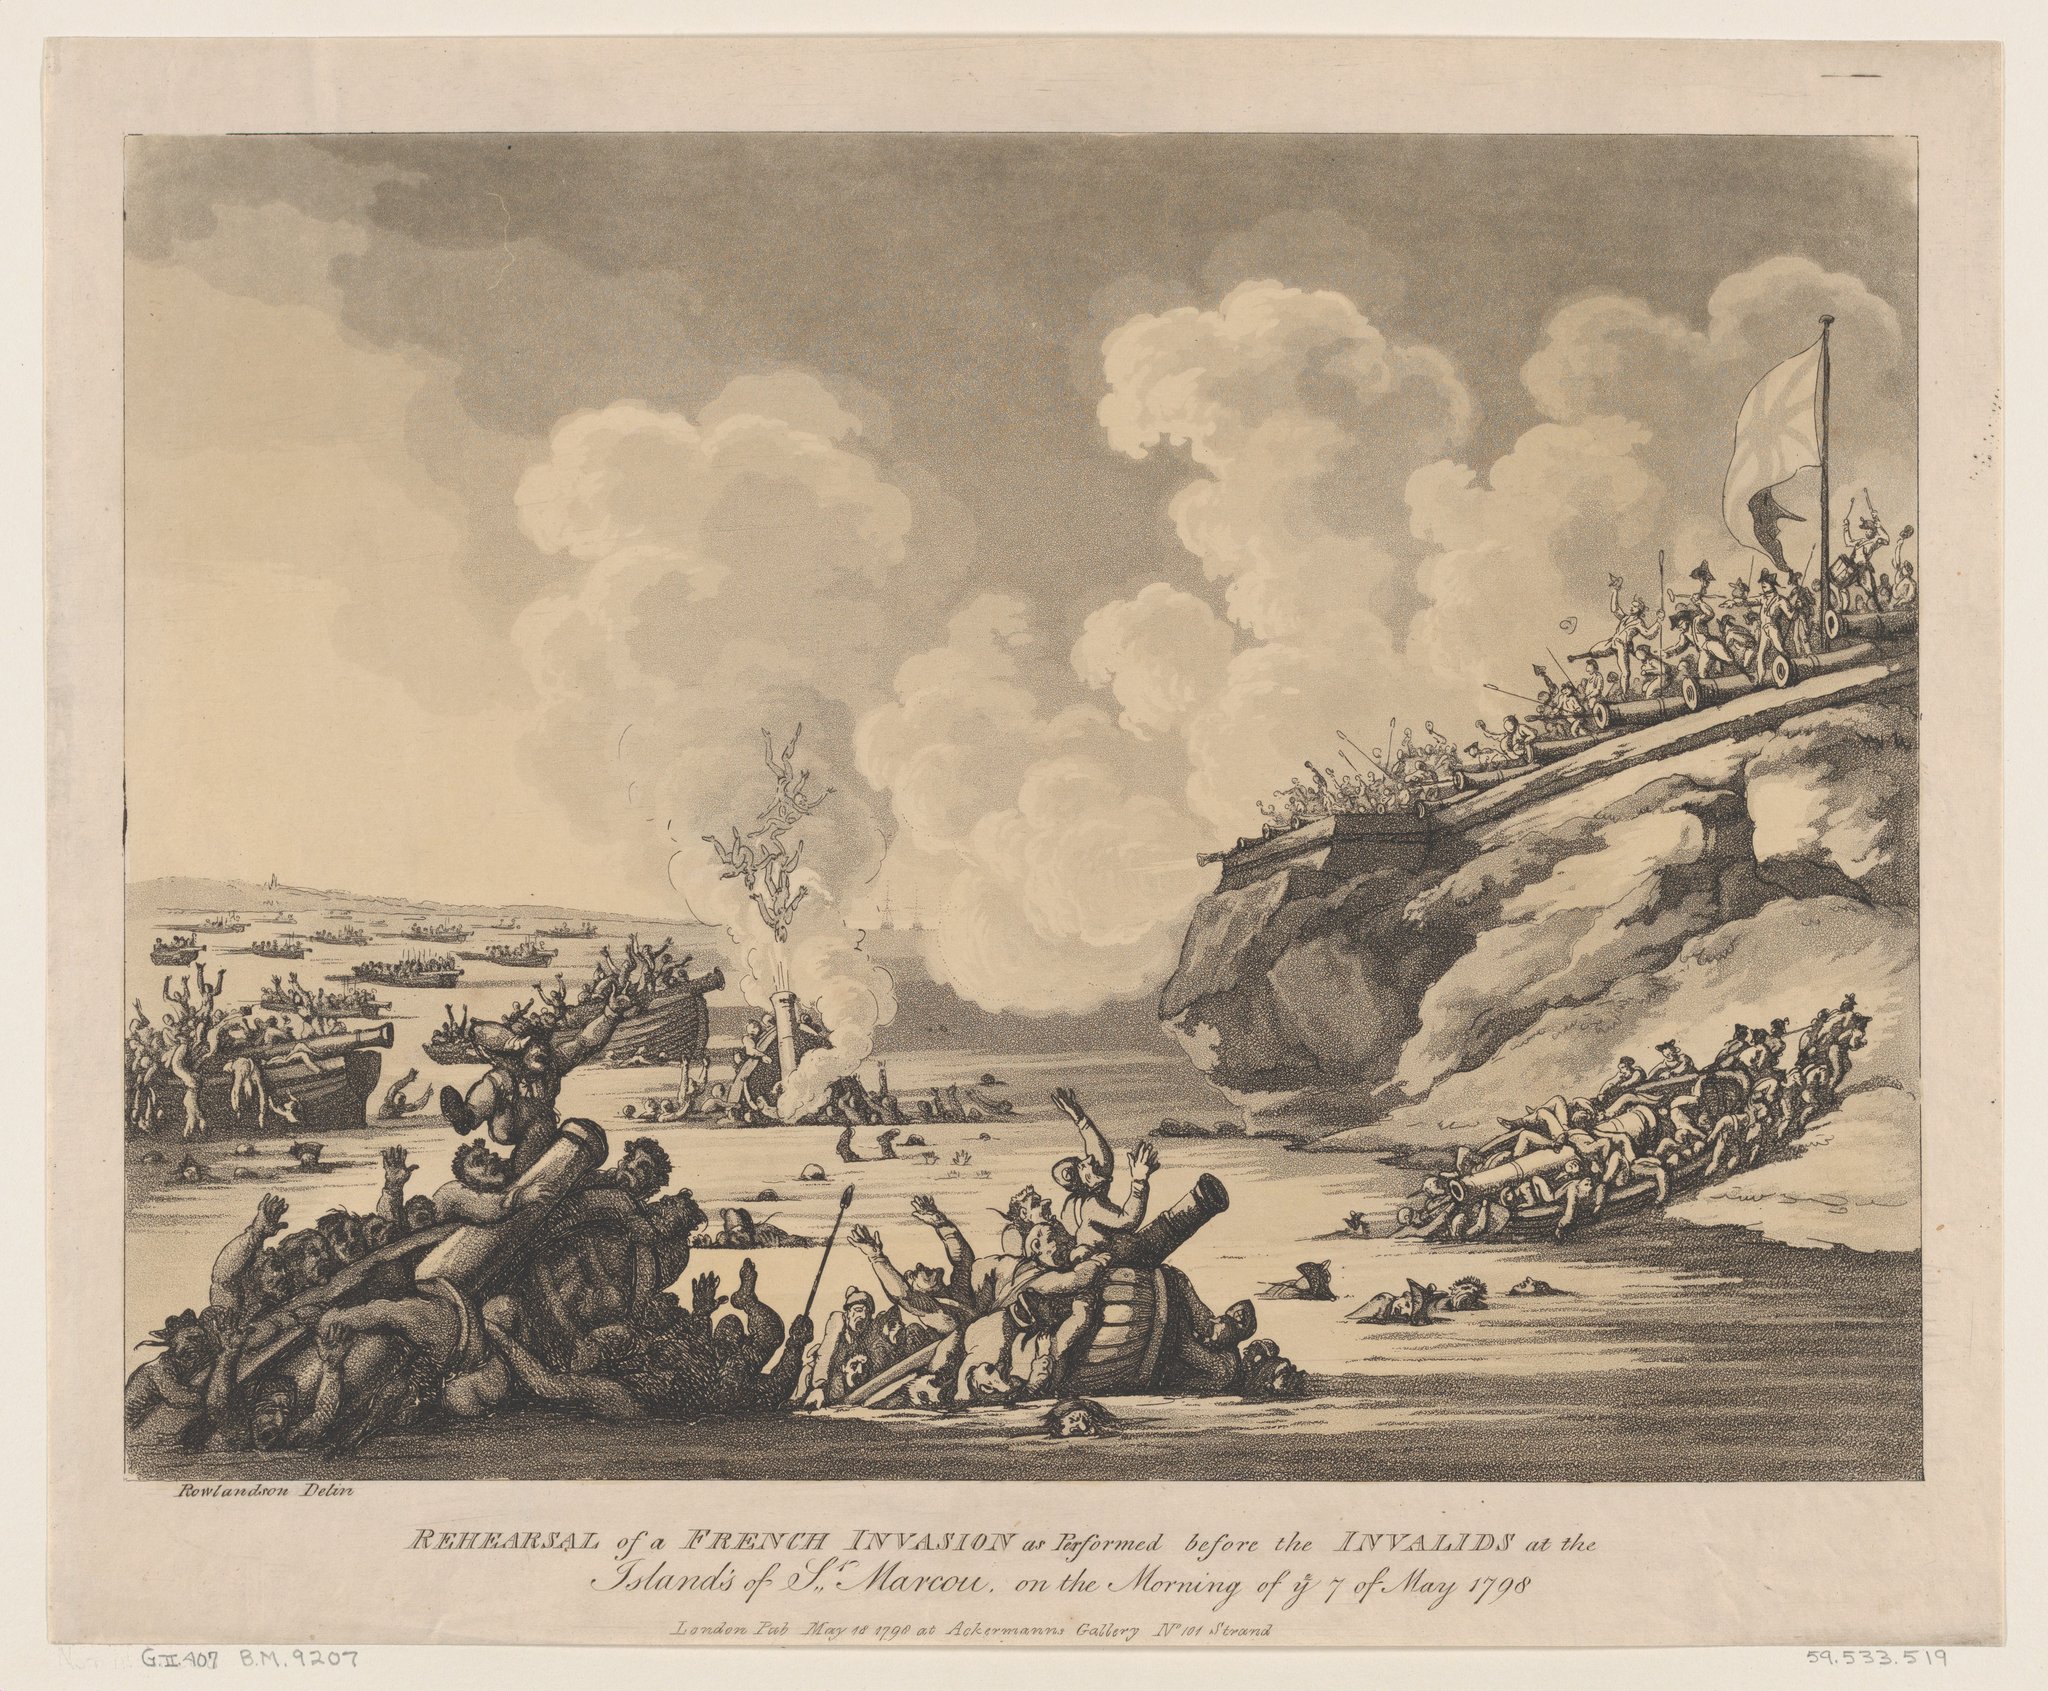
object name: print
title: Rehearsal of a French Invasion as Performed before the Invalids at the Islands of St Marcou on the Morning of the 7th of May 1798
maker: thomas rowlandson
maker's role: artist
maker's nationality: british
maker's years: 1757-1827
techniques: aquatint, etching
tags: wars,soldiers,cannons,flags,boats